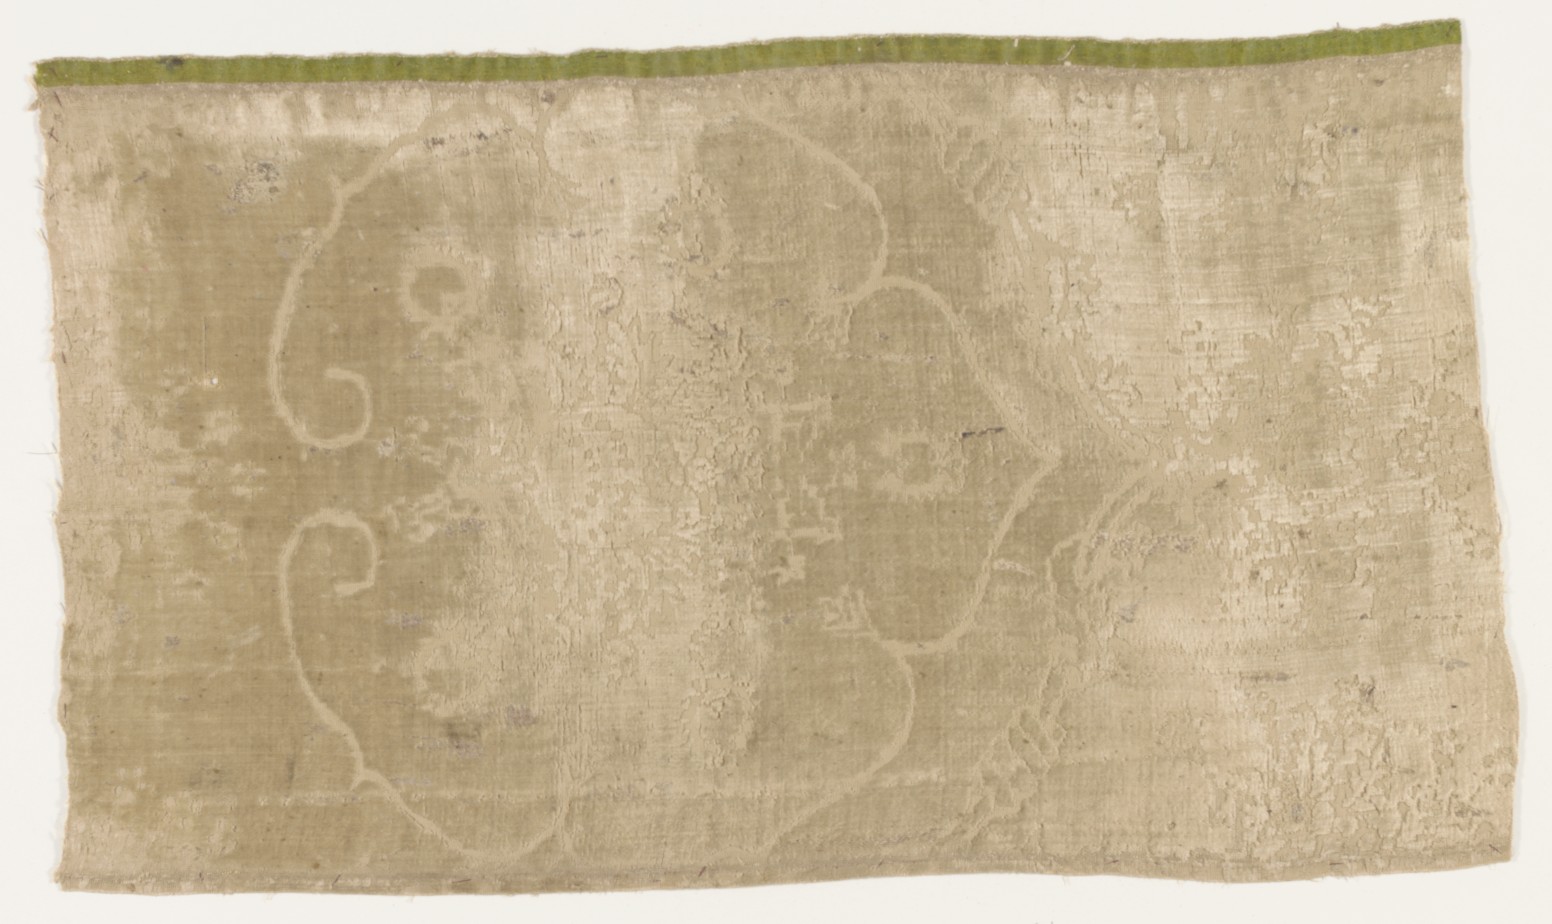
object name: fragment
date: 1401-1600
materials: silk